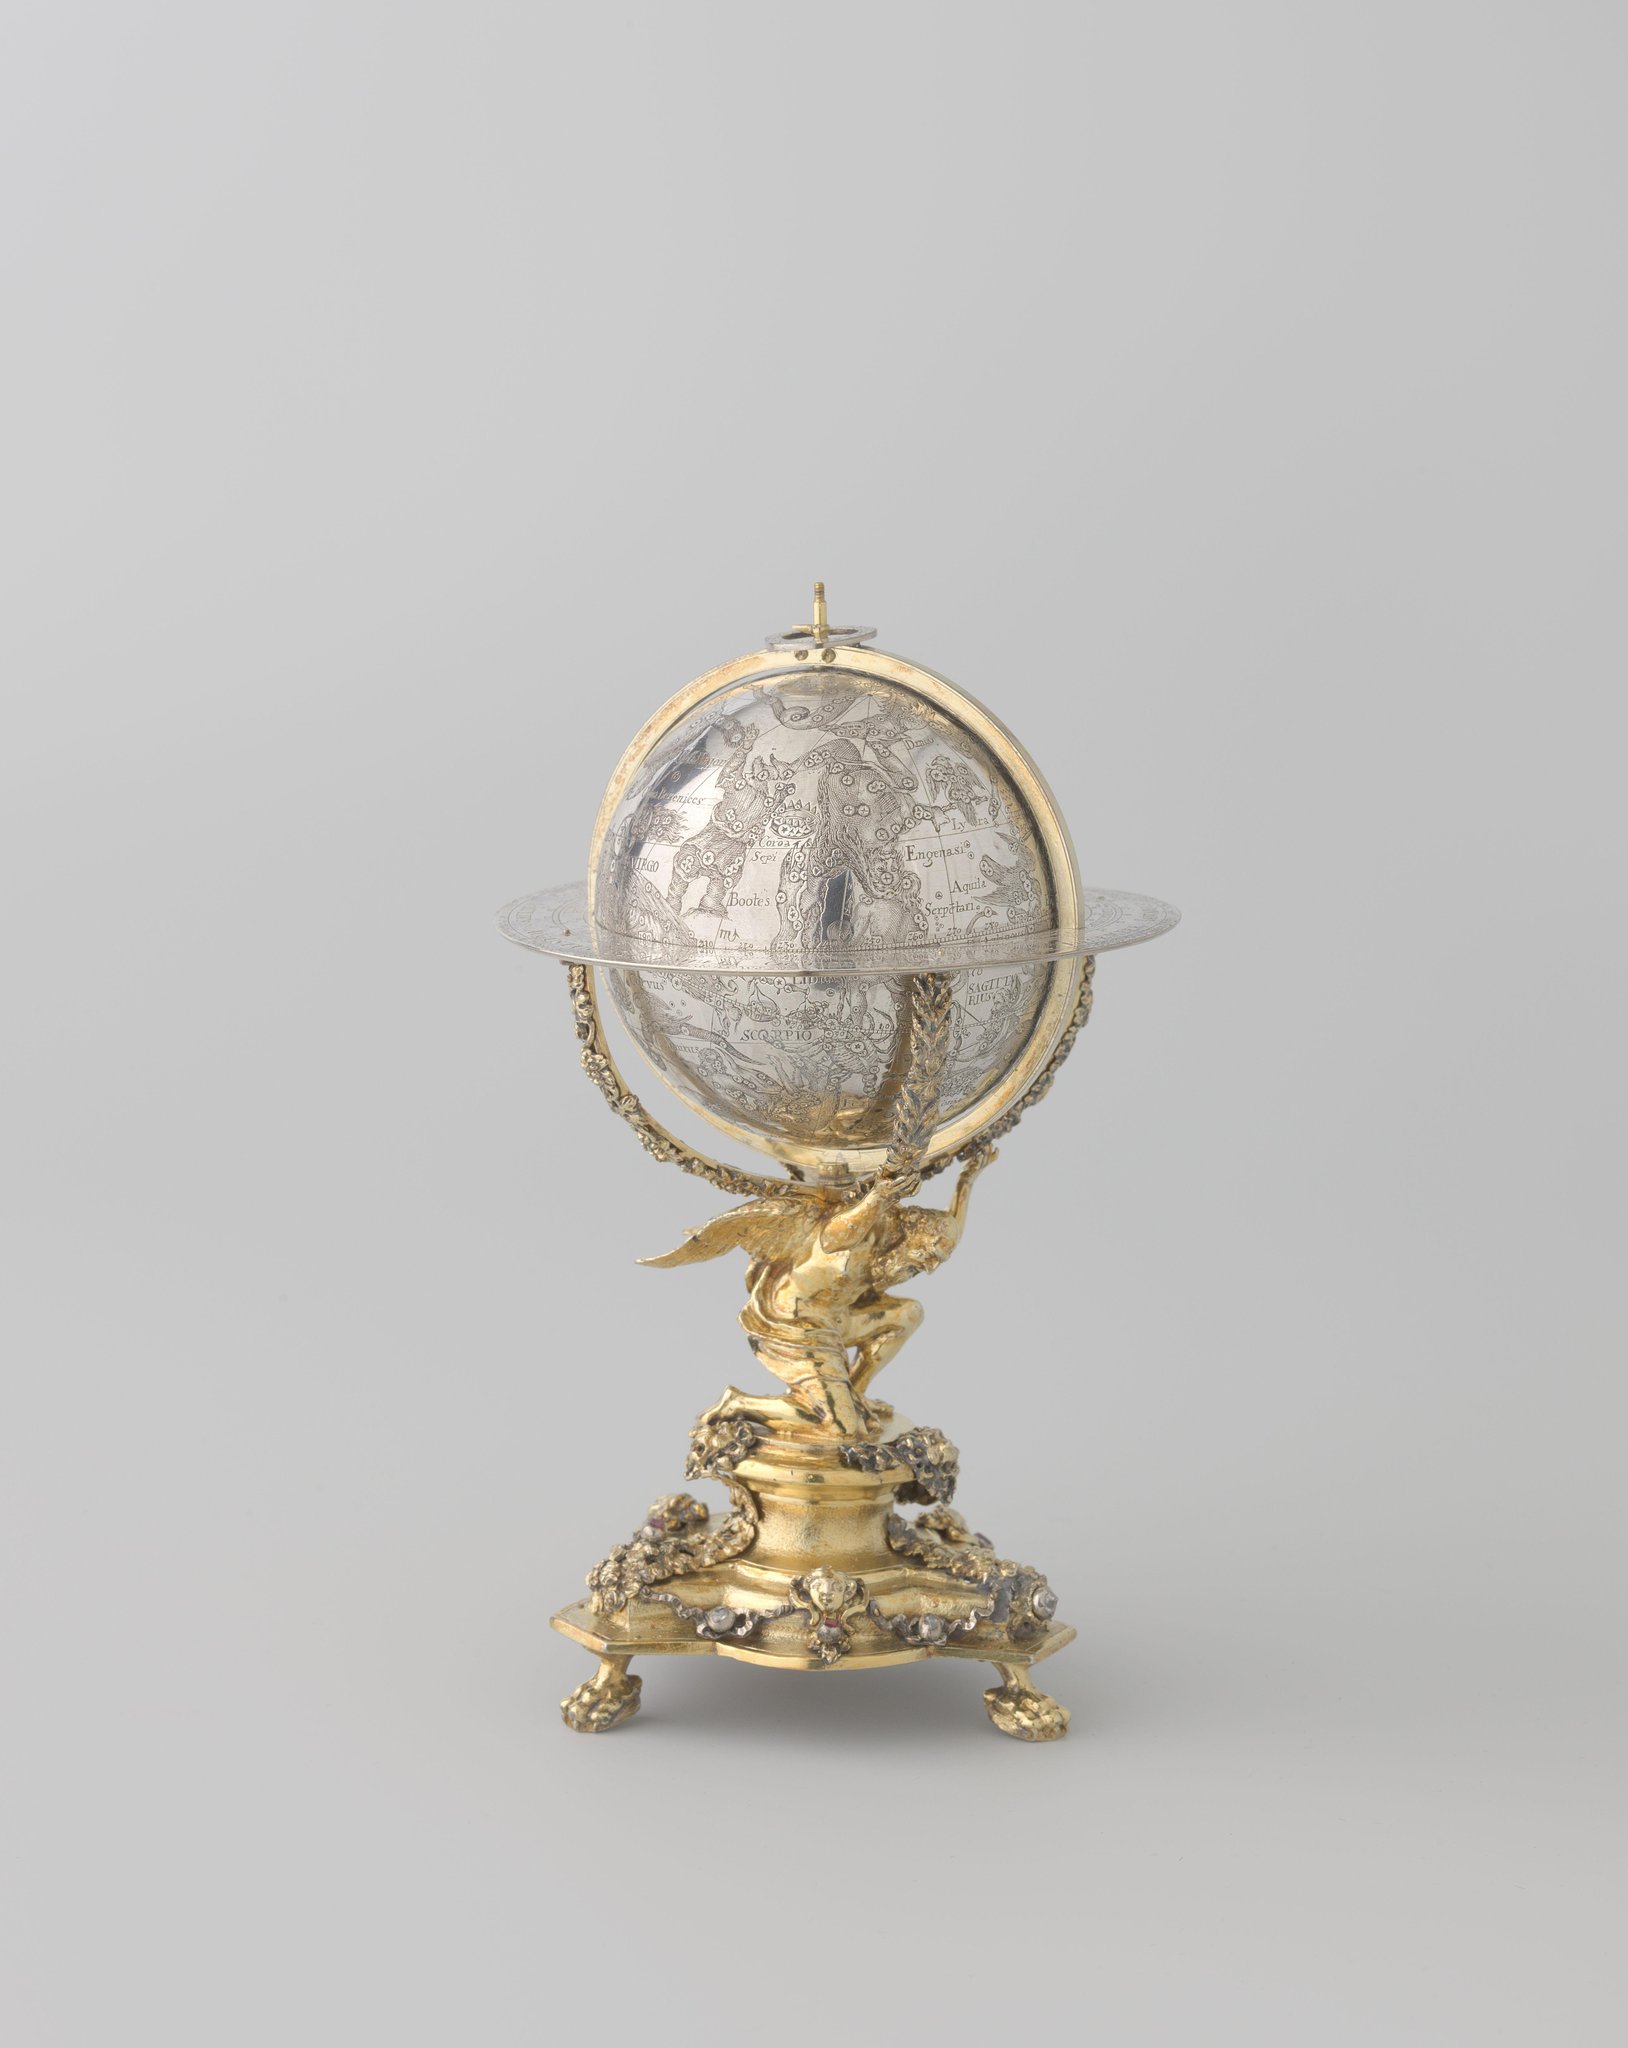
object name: globe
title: Globe van zilver met aardbol en hemelbol versierd met inscriptie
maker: joh. christoph schmidt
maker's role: jeweler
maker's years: 1657-1732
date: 1709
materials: diamond, gemstone, silver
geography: augsburg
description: Two globes. Silver, diamonds and rubies. Augsburg, 1709, by Johann Christoph Schmidt.